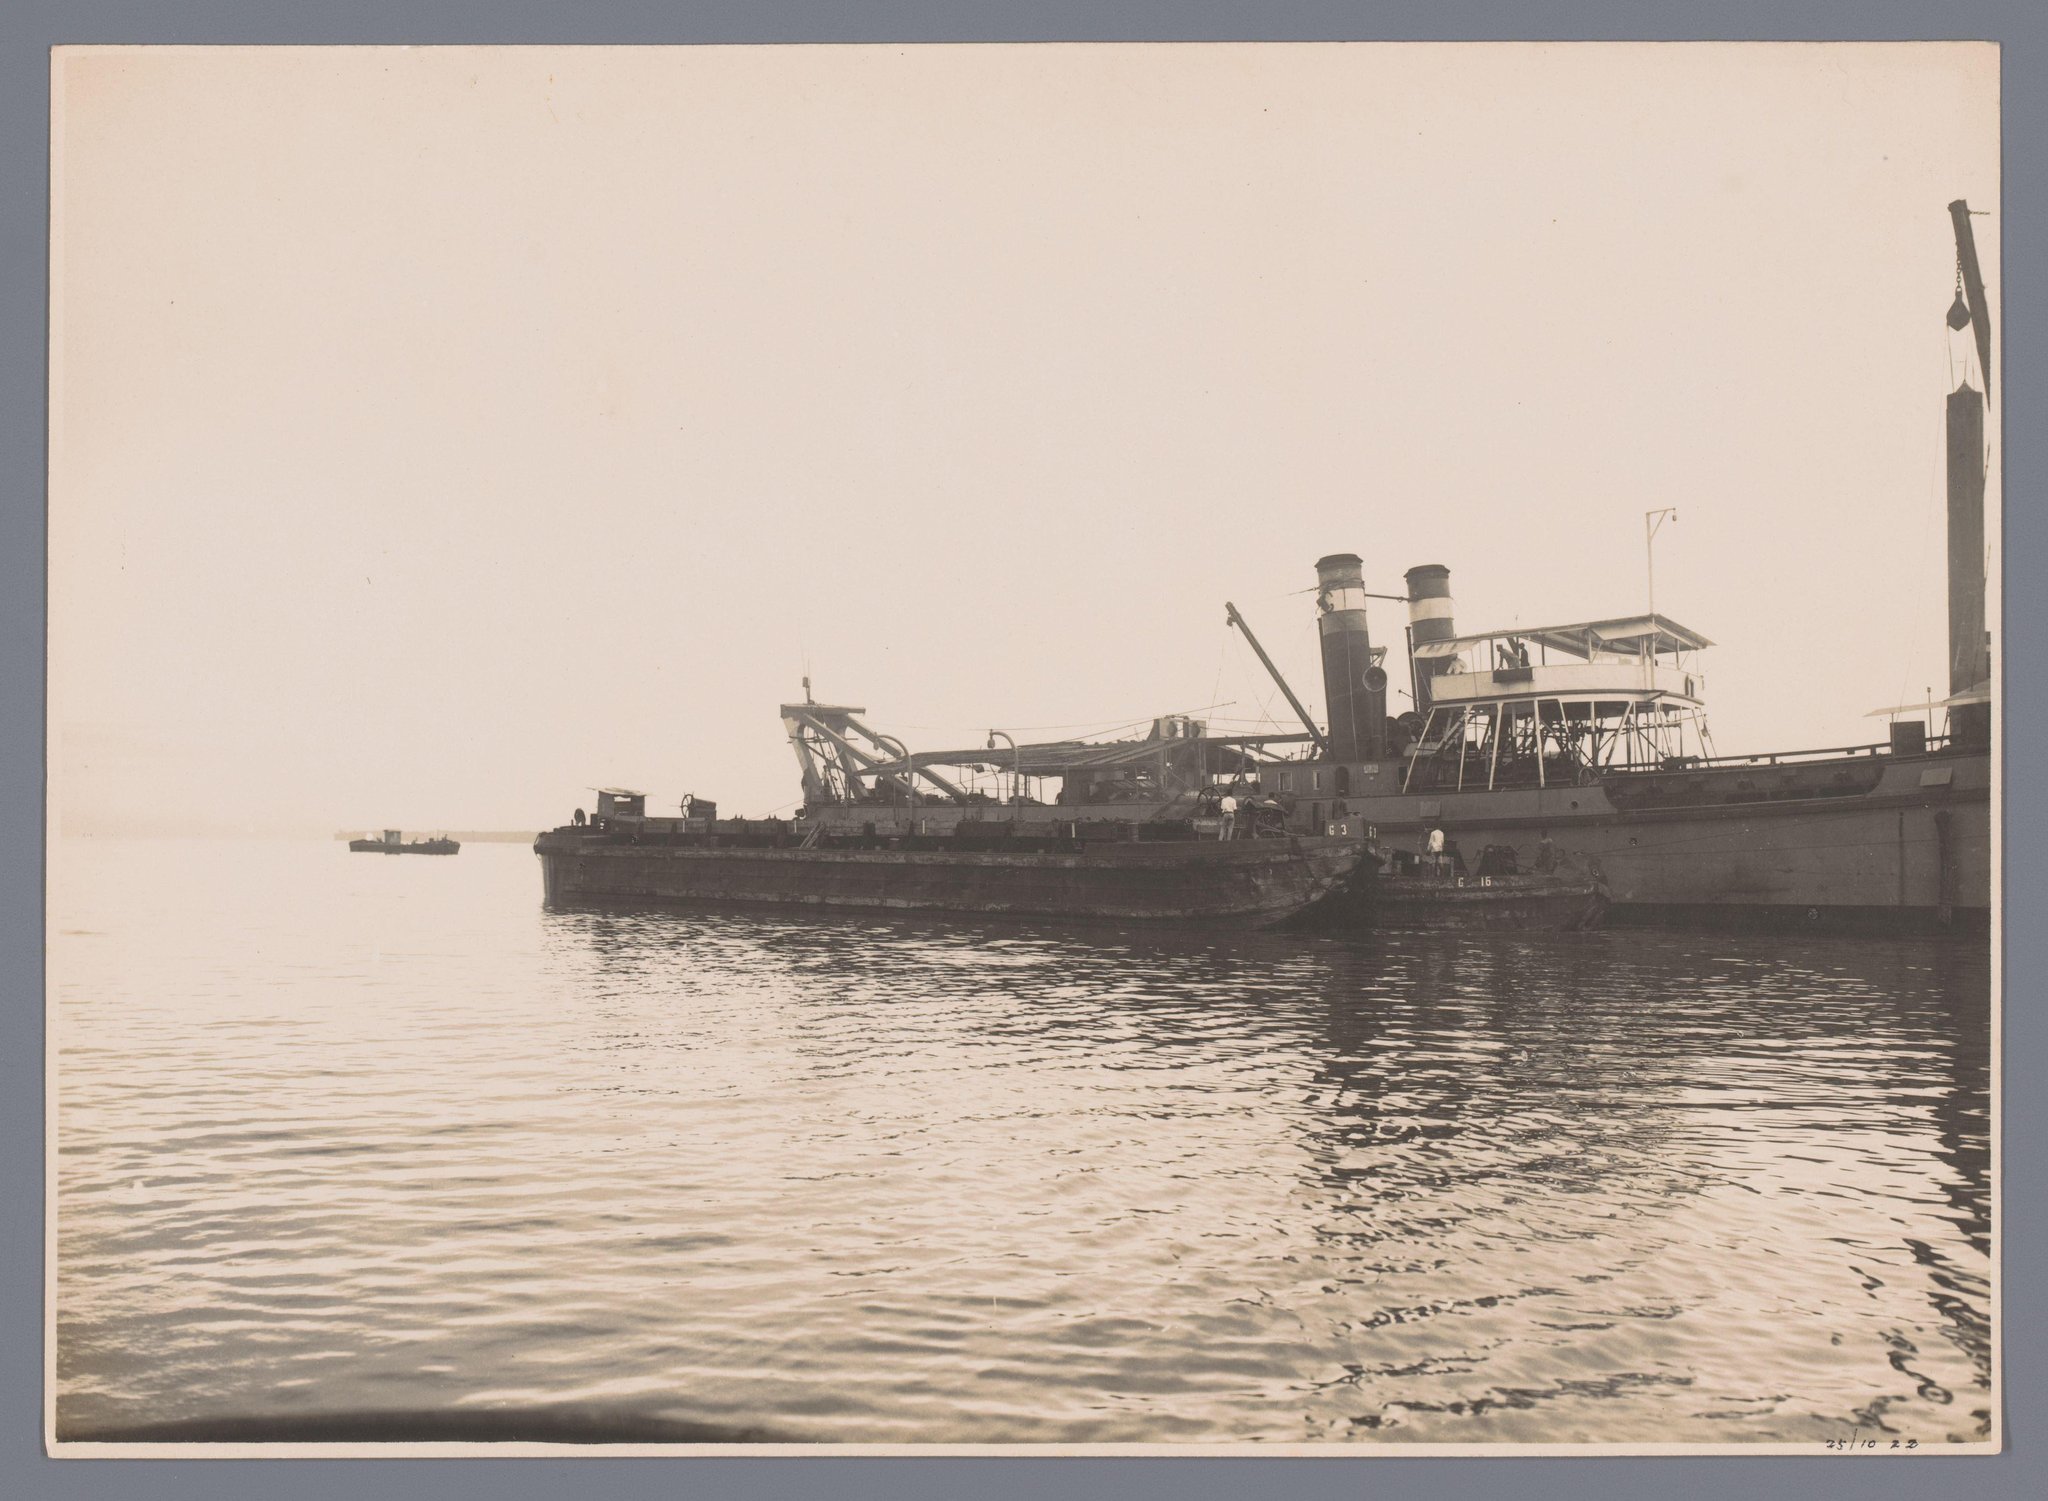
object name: photograph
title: Oceaanhaven Belawan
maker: Anonymous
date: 1922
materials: photographic support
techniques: gelatin silver print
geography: belawan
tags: dredge, dredging machine, building-site, steamship, motorship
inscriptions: annotation: ‘No. 268 Hopper "G.G. Idenburg"’, date: ‘25/10-22’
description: De hopperzuiger 'G.G. Idenburg'. Genummerd: 268. Onderdeel van de groep van losse foto's over de aanleg van de haven Belawan aan de kust voor Medan, Sumatra 1921-1922.